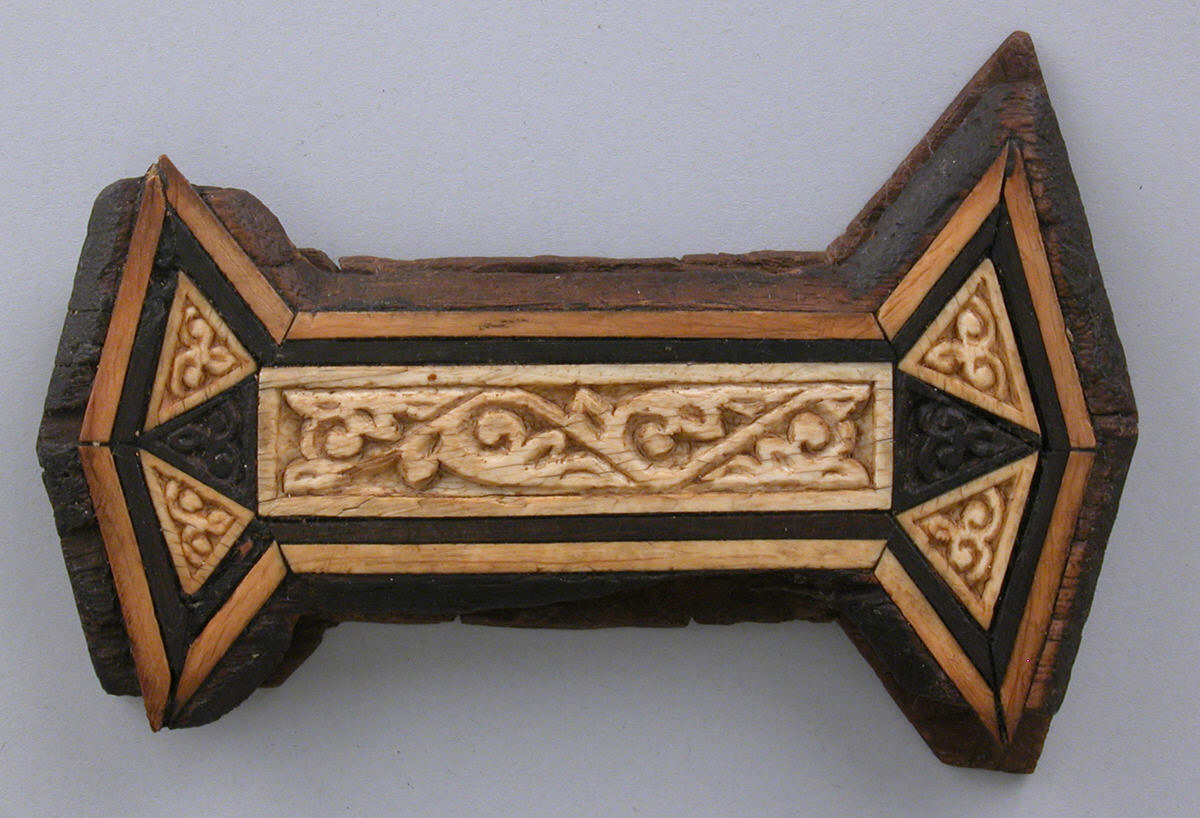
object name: panel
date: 1201-1300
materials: ivory, wood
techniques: carving, inlay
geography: egypt